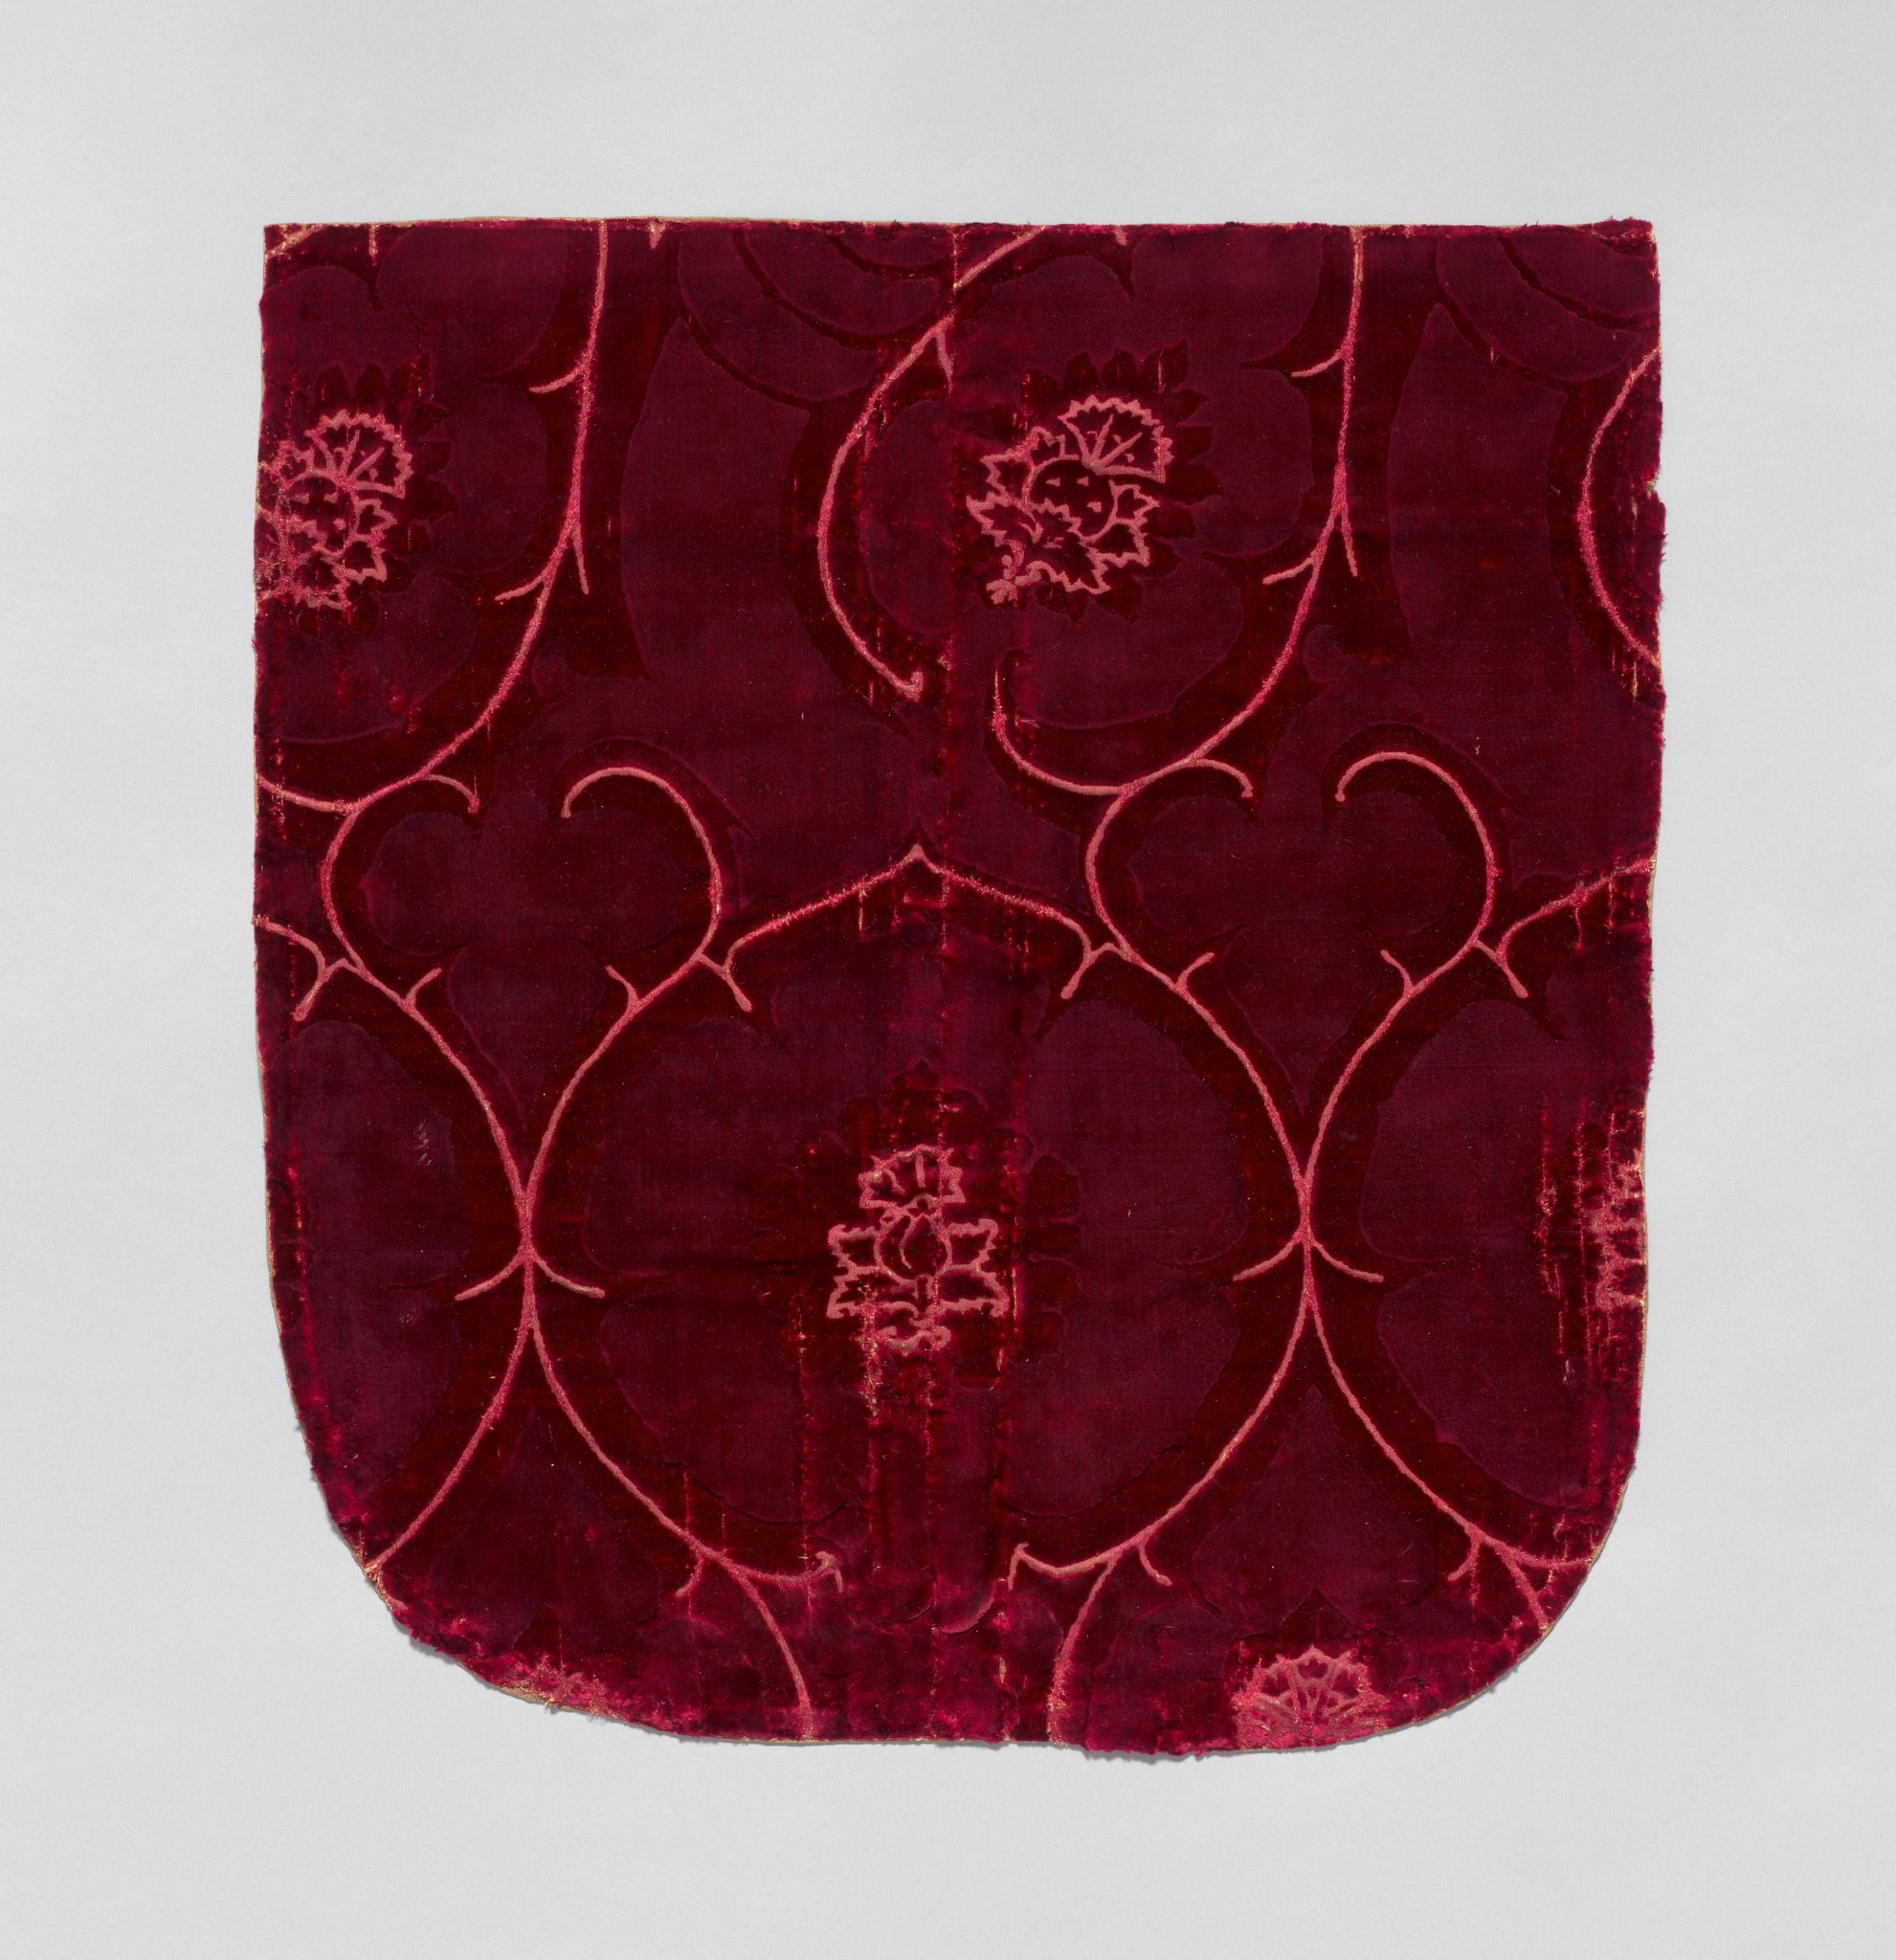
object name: piece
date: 1467-1500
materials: silk